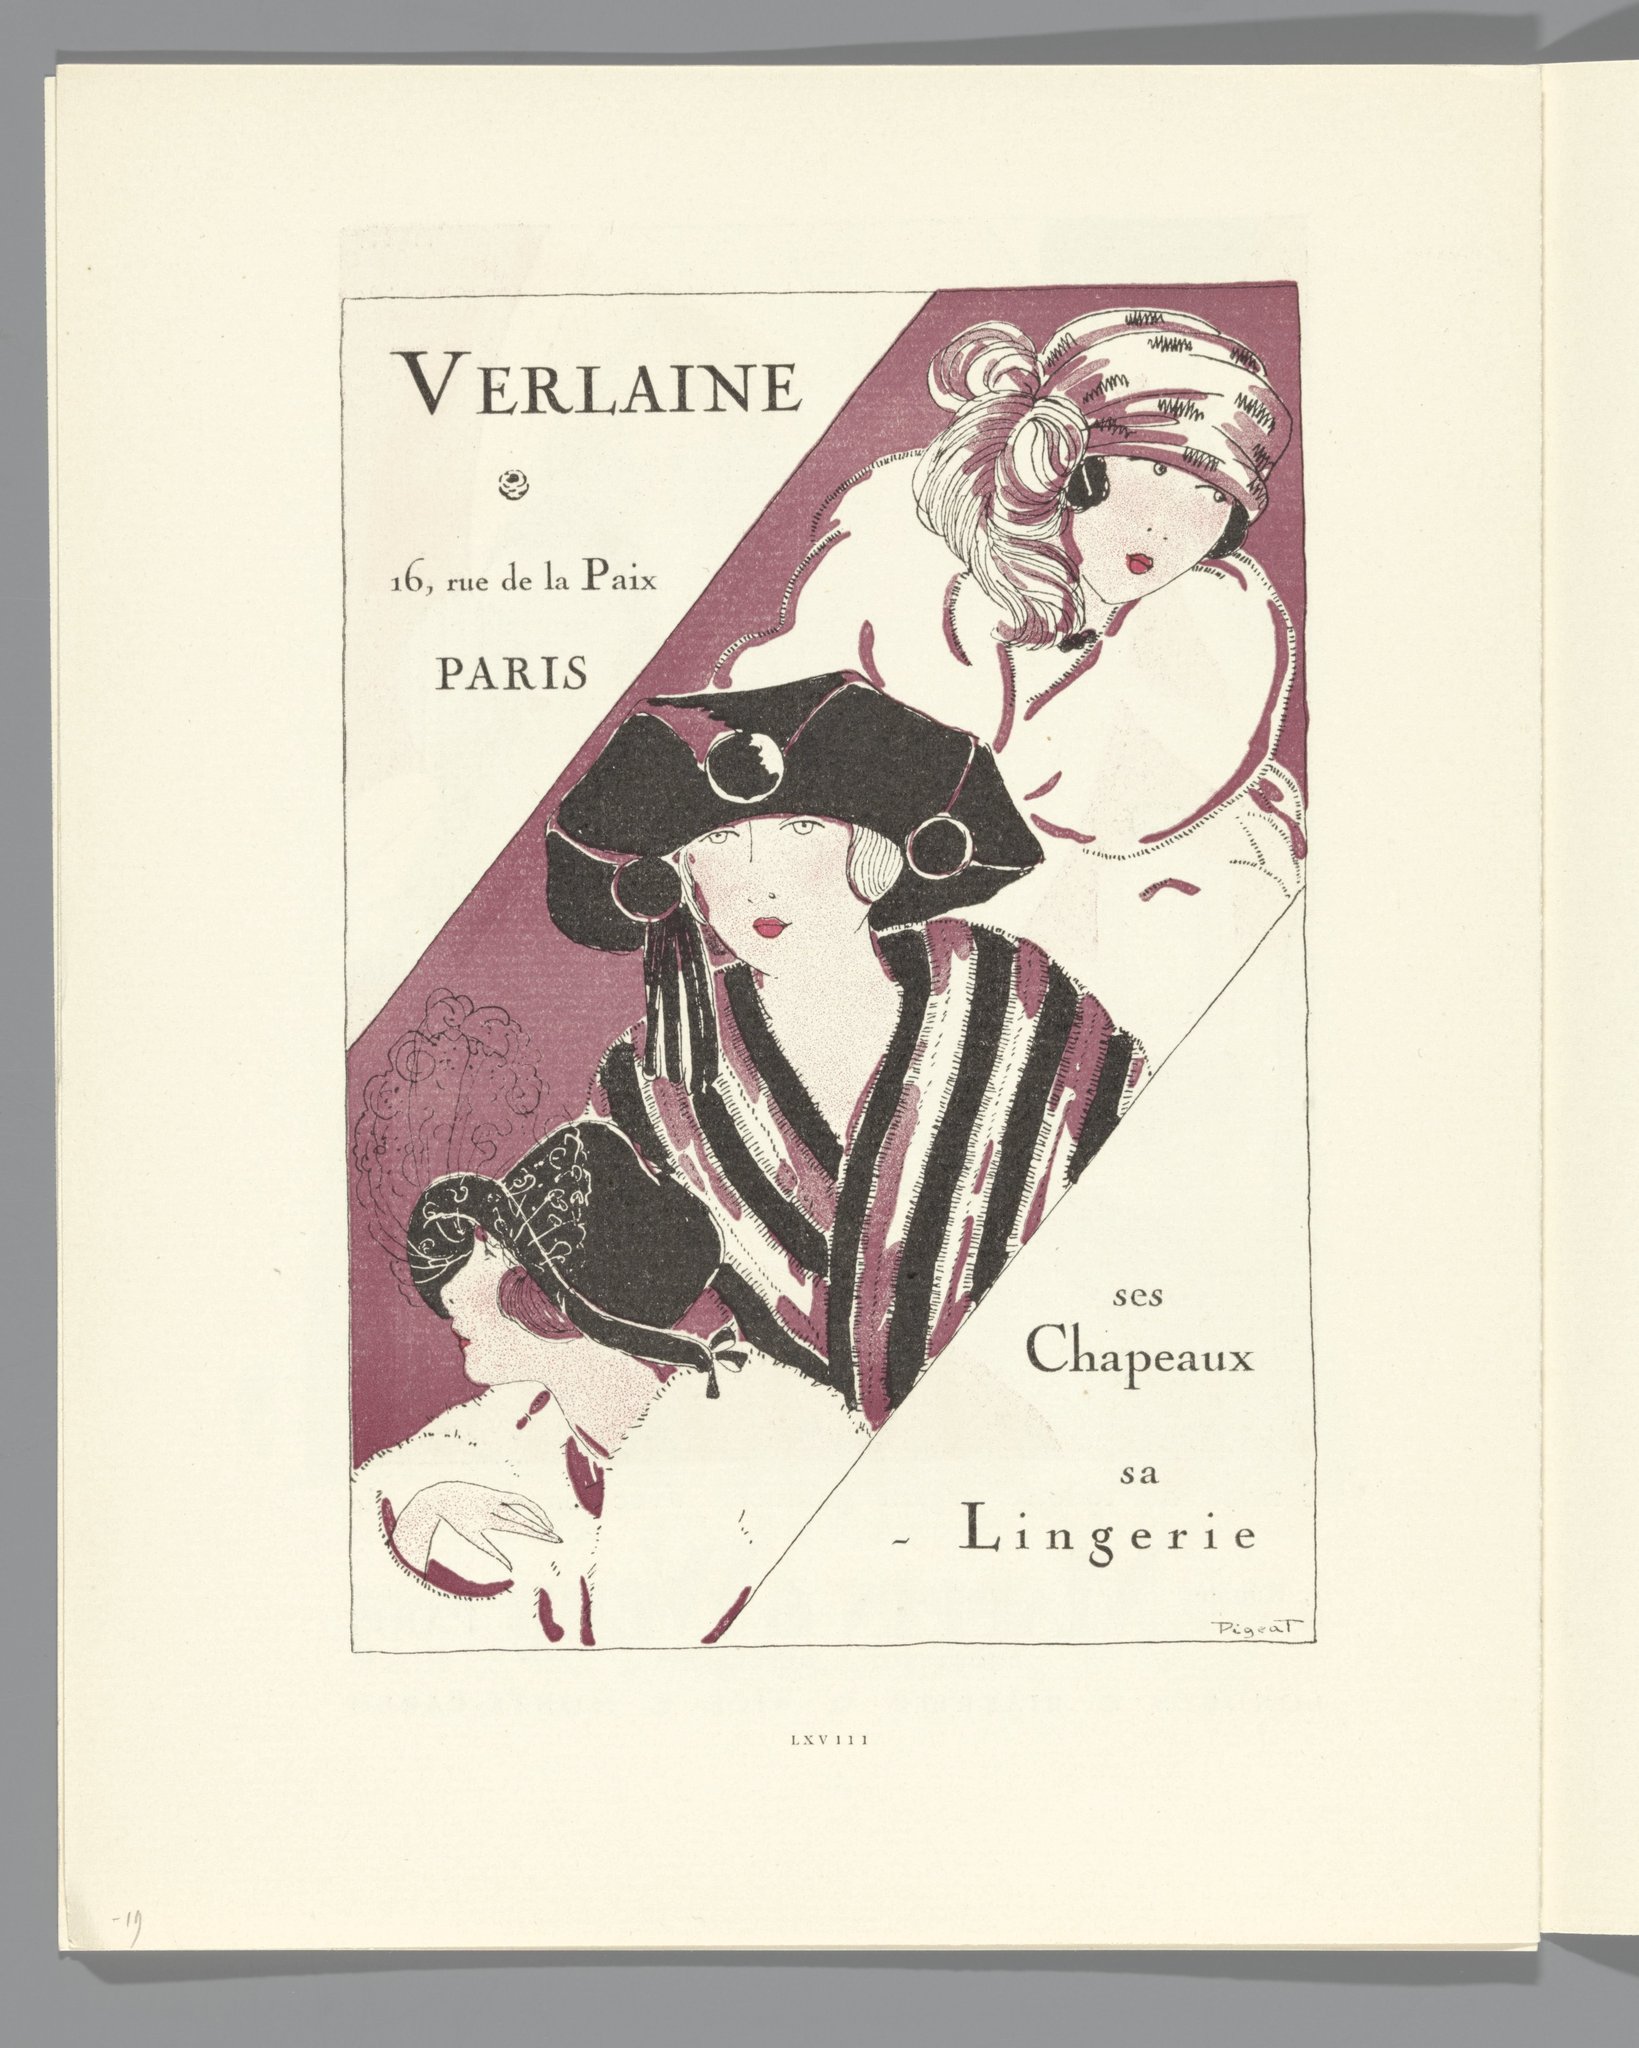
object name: fashion print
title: Gazette du Bon Ton, 1920 - No. 8, p. LXVIII: advertentie Verlaine, rue de la Paix, Paris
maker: lucien vogel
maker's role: publisher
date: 1920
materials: paper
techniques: printing, letterpress printing, photochemical processes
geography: london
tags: fashion plates, head-gear: hat (+ women's clothes)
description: Advertentie van de hoeden- en lingeriewinkel Verlaine, Parijs. (Verlaine, ses Chapeaux et sa Lingerie). Drie typen hoeden schuin boven elkaar. Pag. LXVIII in Gazette du Bon Ton, 1920 - No. 8